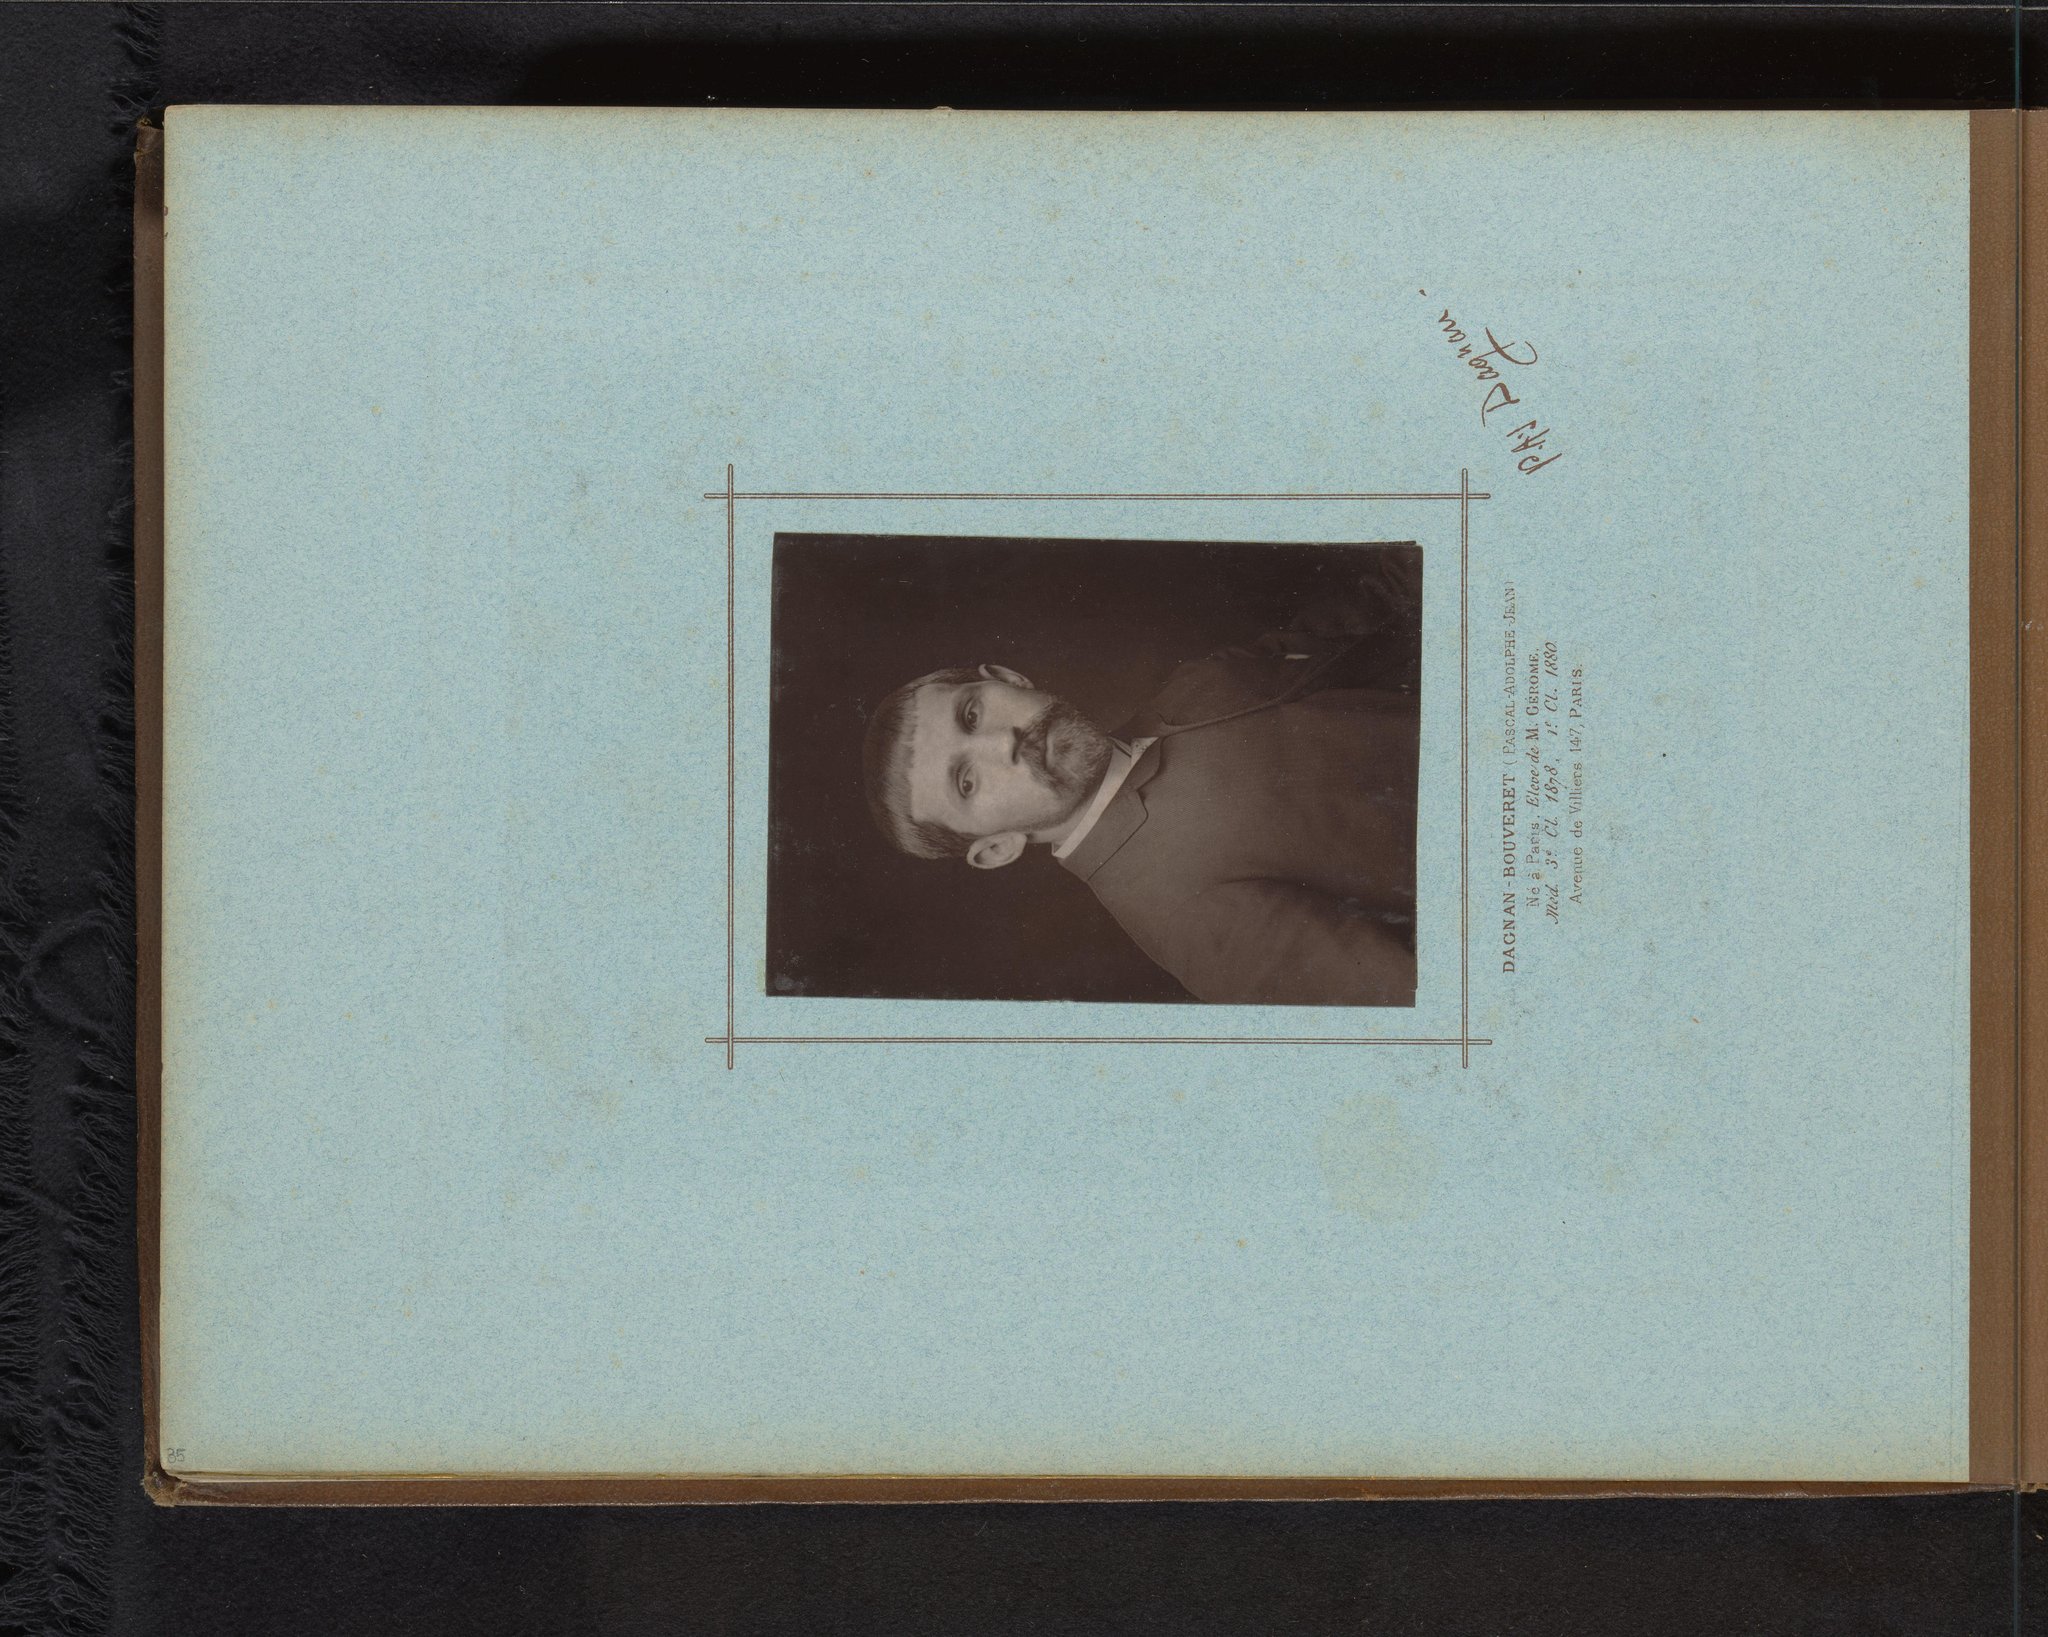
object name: page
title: Portret van Pascal-Adolphe-Jean Dagnan-Bouveret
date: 1879-1884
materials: paper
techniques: woodburytype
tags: paris, painter, draughtsman, pascal-adolphe-jean dagnan-bouveret, historical persons, portrait, self-portrait of painter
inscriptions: signature: ‘P.A.J. Dagnan.’, inscription: ‘DAGNAN-BOUVERET (Pascal-Adolphe-Jean)/ Né à Paris. Elève de M. Gérôme,/ Méd. 3e. Cl. 1878, 1e. Cl. 1880./ Avenue de Villiers, 147, Paris.’